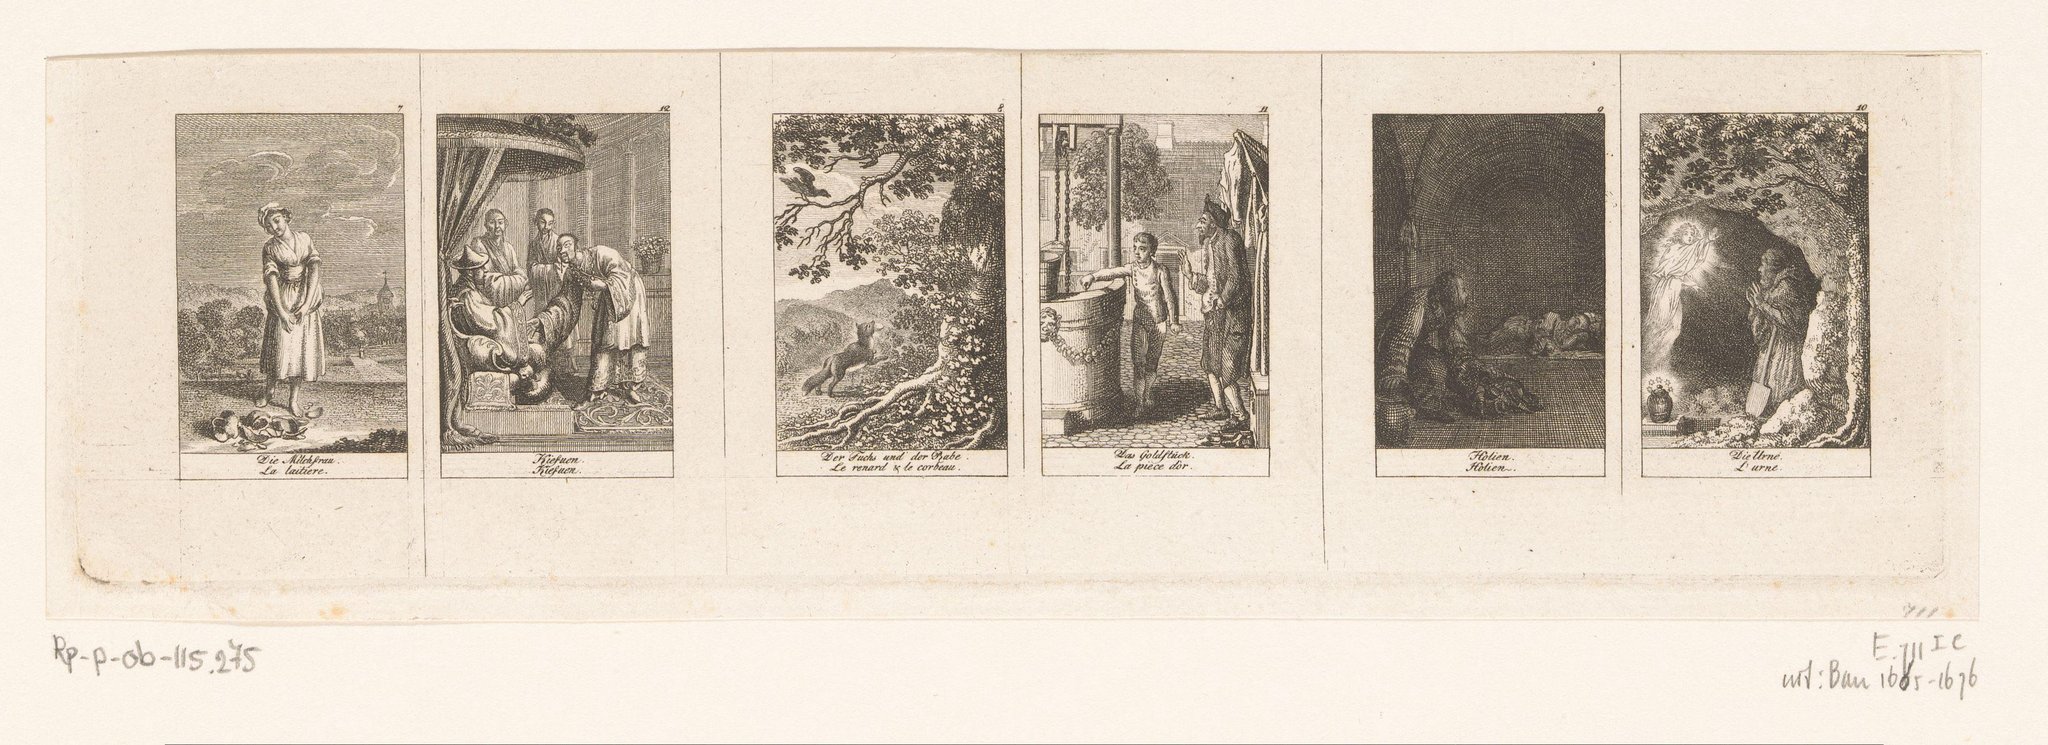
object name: print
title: Zes voorstellingen uit de fabels en verhalen van Gellert, Gleim, Hagedorn, Lichtwer en Pfeffel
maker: daniel nikolaus chodowiecki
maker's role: draughtsman, print maker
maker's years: 1726-1801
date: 1793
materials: paper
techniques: etching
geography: berlin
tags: chinese, literature, fable of the fox and the raven, coin, fables, spirit, ghost, urn, milkmaid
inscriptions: collector's mark: Lugt 2228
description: Latere staat gebruikt voor: Kleiner Taschen Calender auf das gemeine Jahr 1794. Berlijn: s.n., [1793].